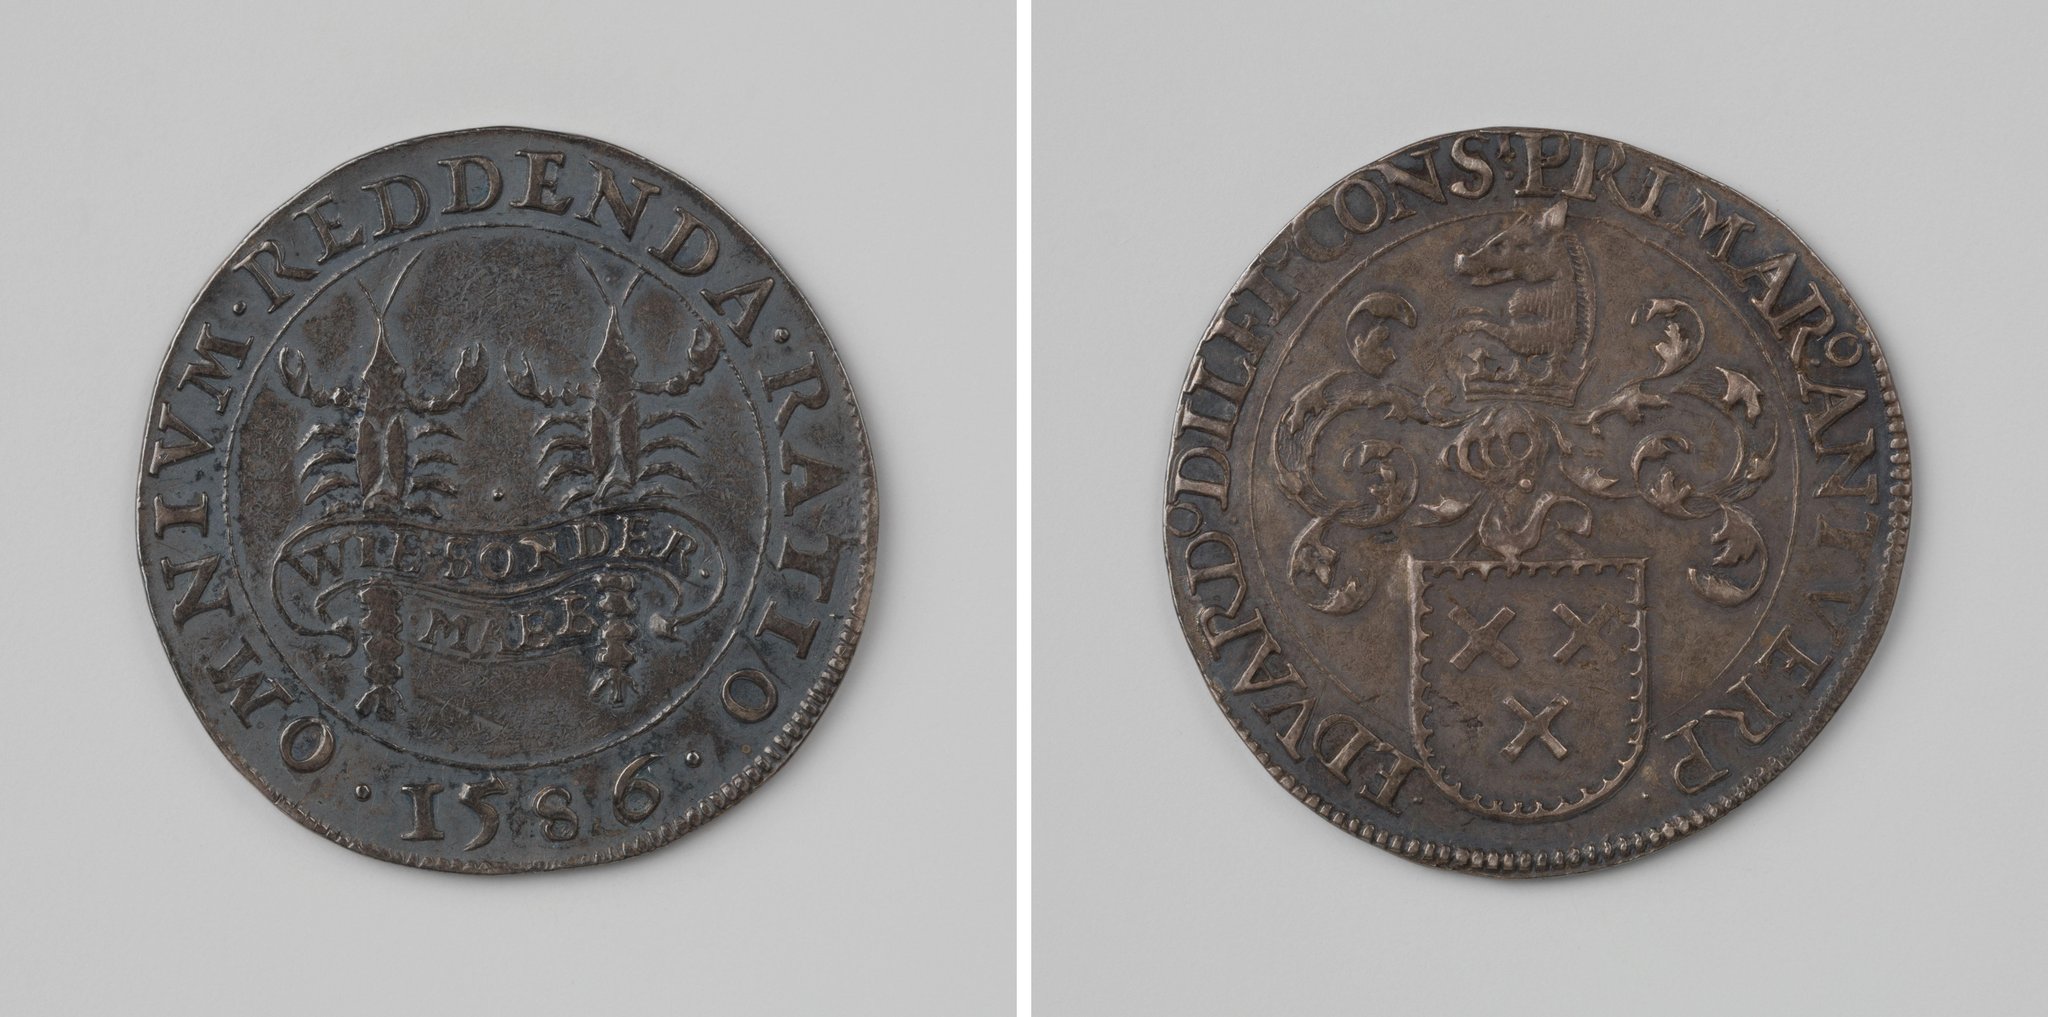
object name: jeton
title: Eduard van der Delft van Borghvliet, voorzitter van de raad van Antwerpen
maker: Anonymous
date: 1586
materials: silver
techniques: striking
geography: belgium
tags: antwerp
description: Zilveren penning. Voorzijde: twee kreeften, met elkaar verbonden door wimpel met opschrift binnen omschrift. Keerzijde: wapenschild onder gekroonde helm en dierekop